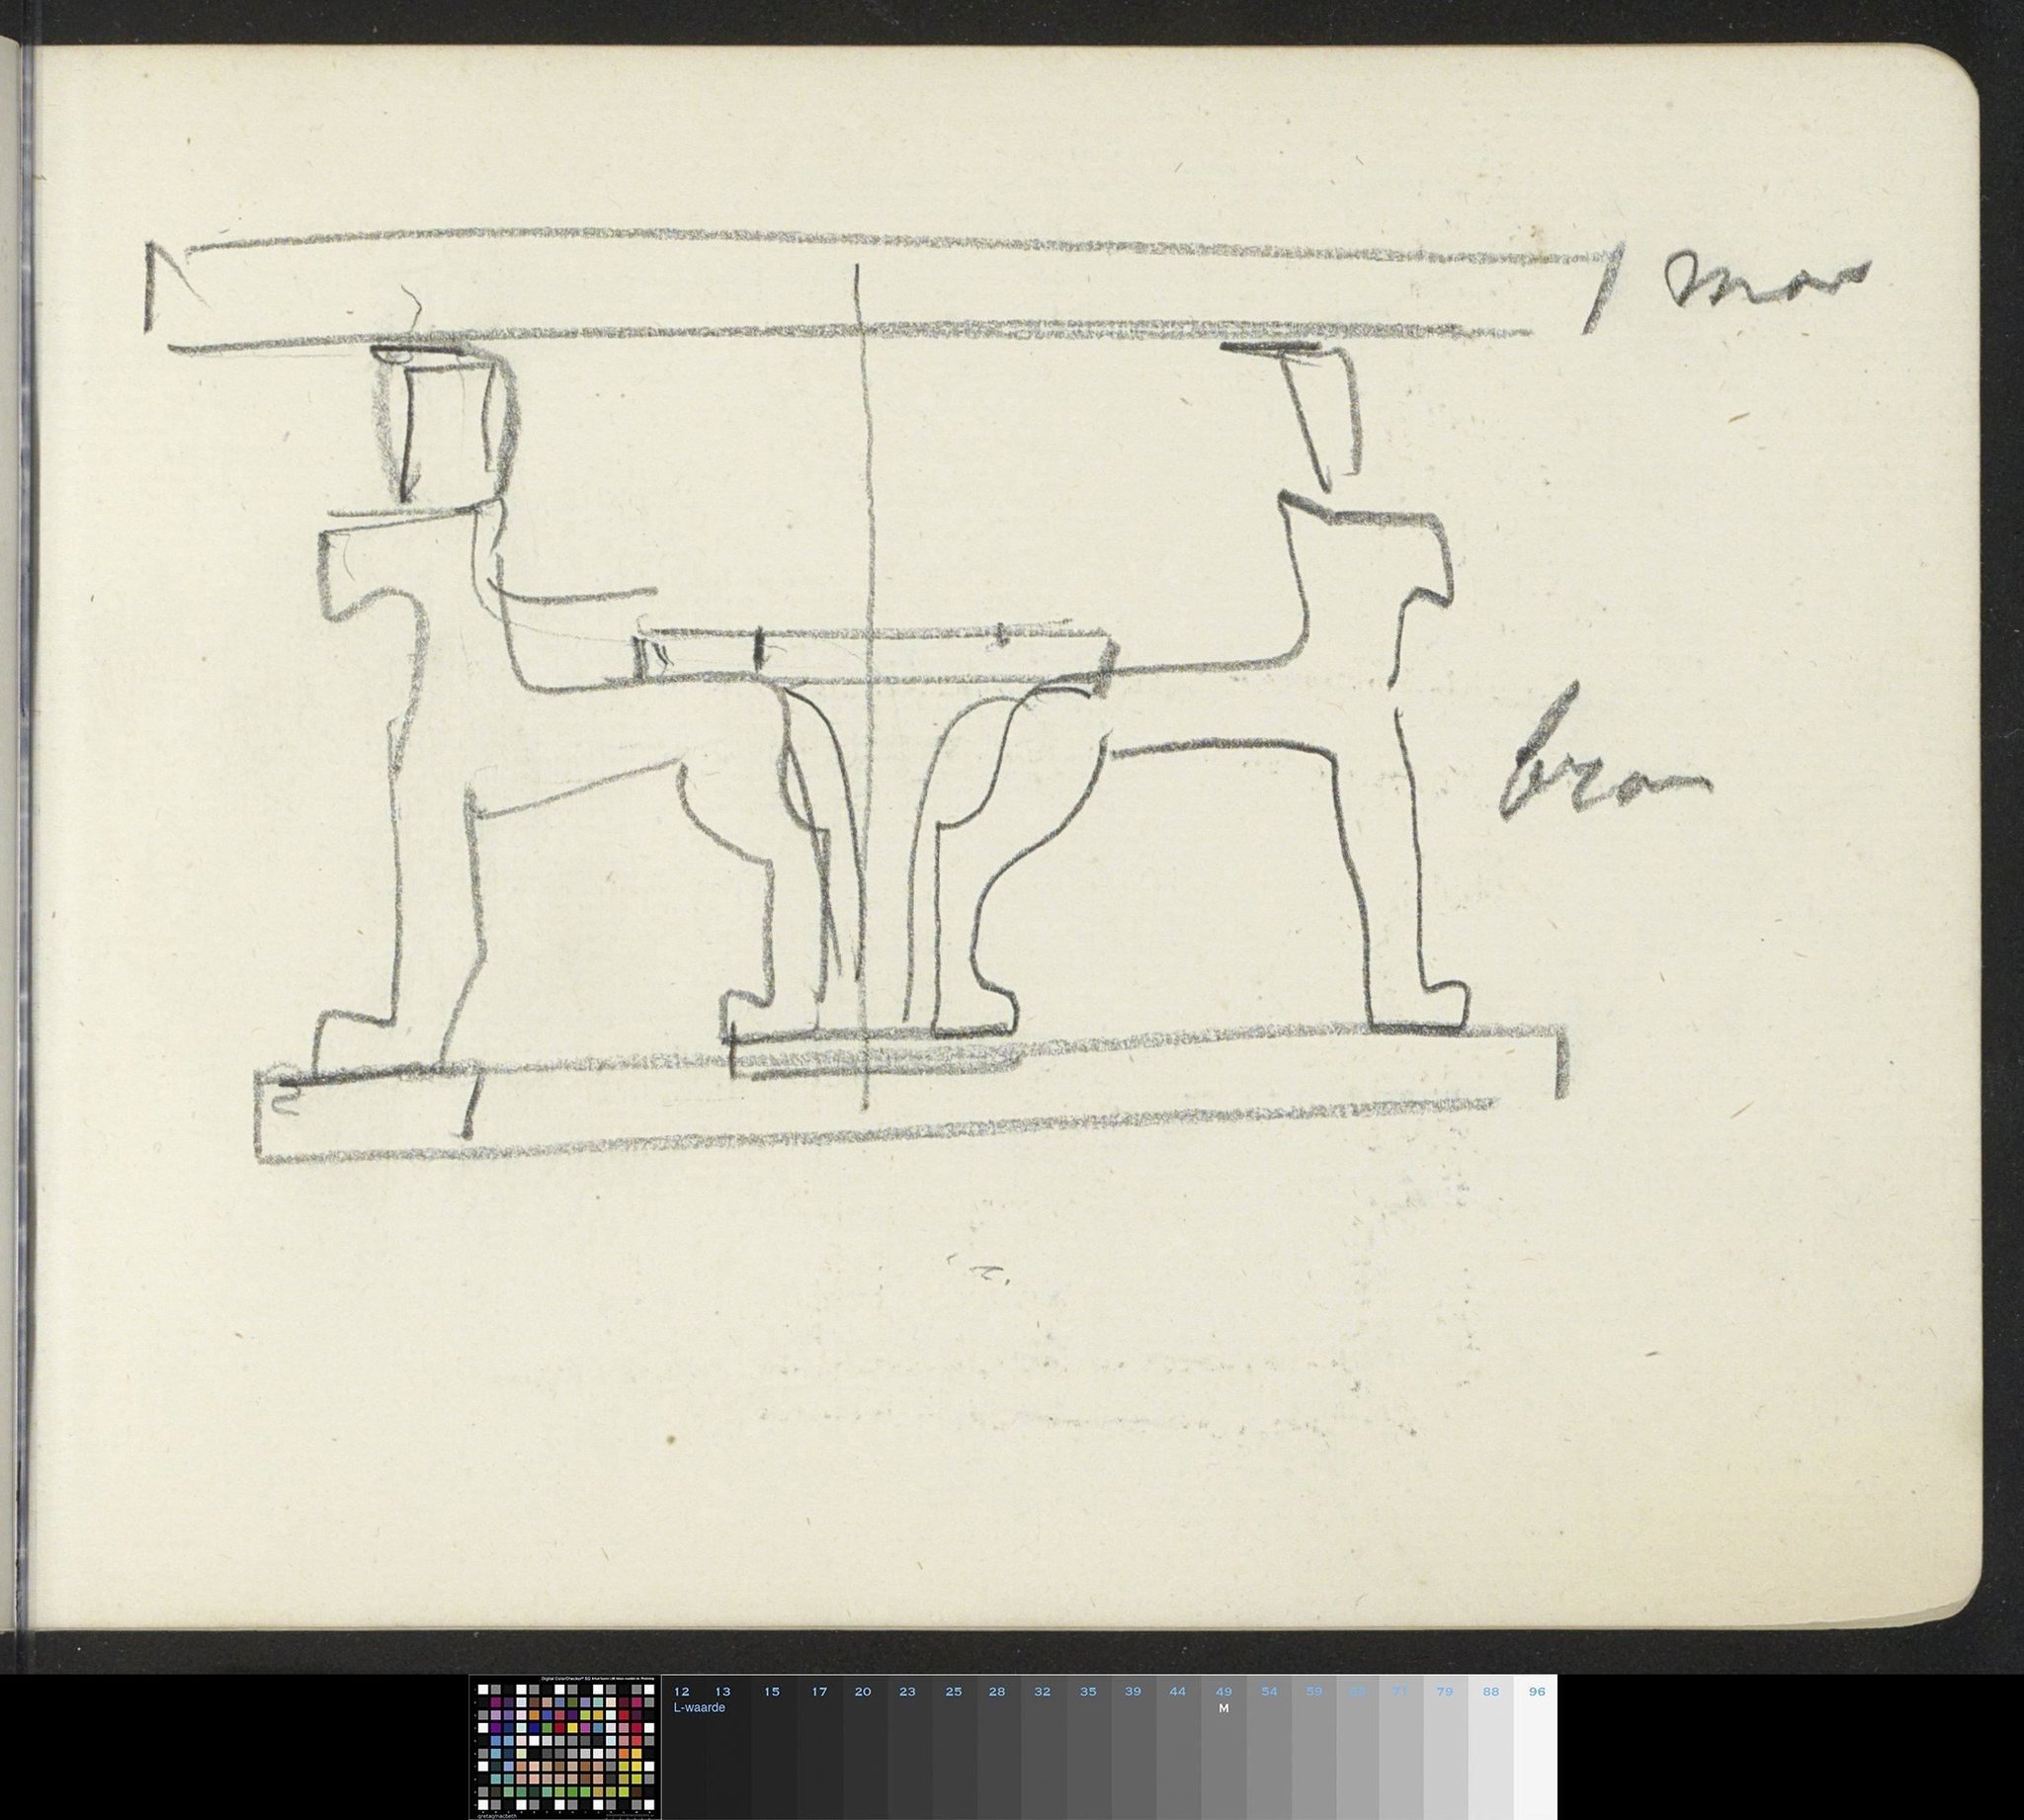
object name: sketchbook leaf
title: Ontwerp voor een tafel met dierlijke ornamenten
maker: carel adolph lion cachet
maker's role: draughtsman, print maker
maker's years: 1864-1945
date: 1928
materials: paper, pencil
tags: ornaments ~ art, table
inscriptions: annotation: ‘ma[...]/ bron’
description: Blad 6 recto uit een schetsboek met 24 bladen.